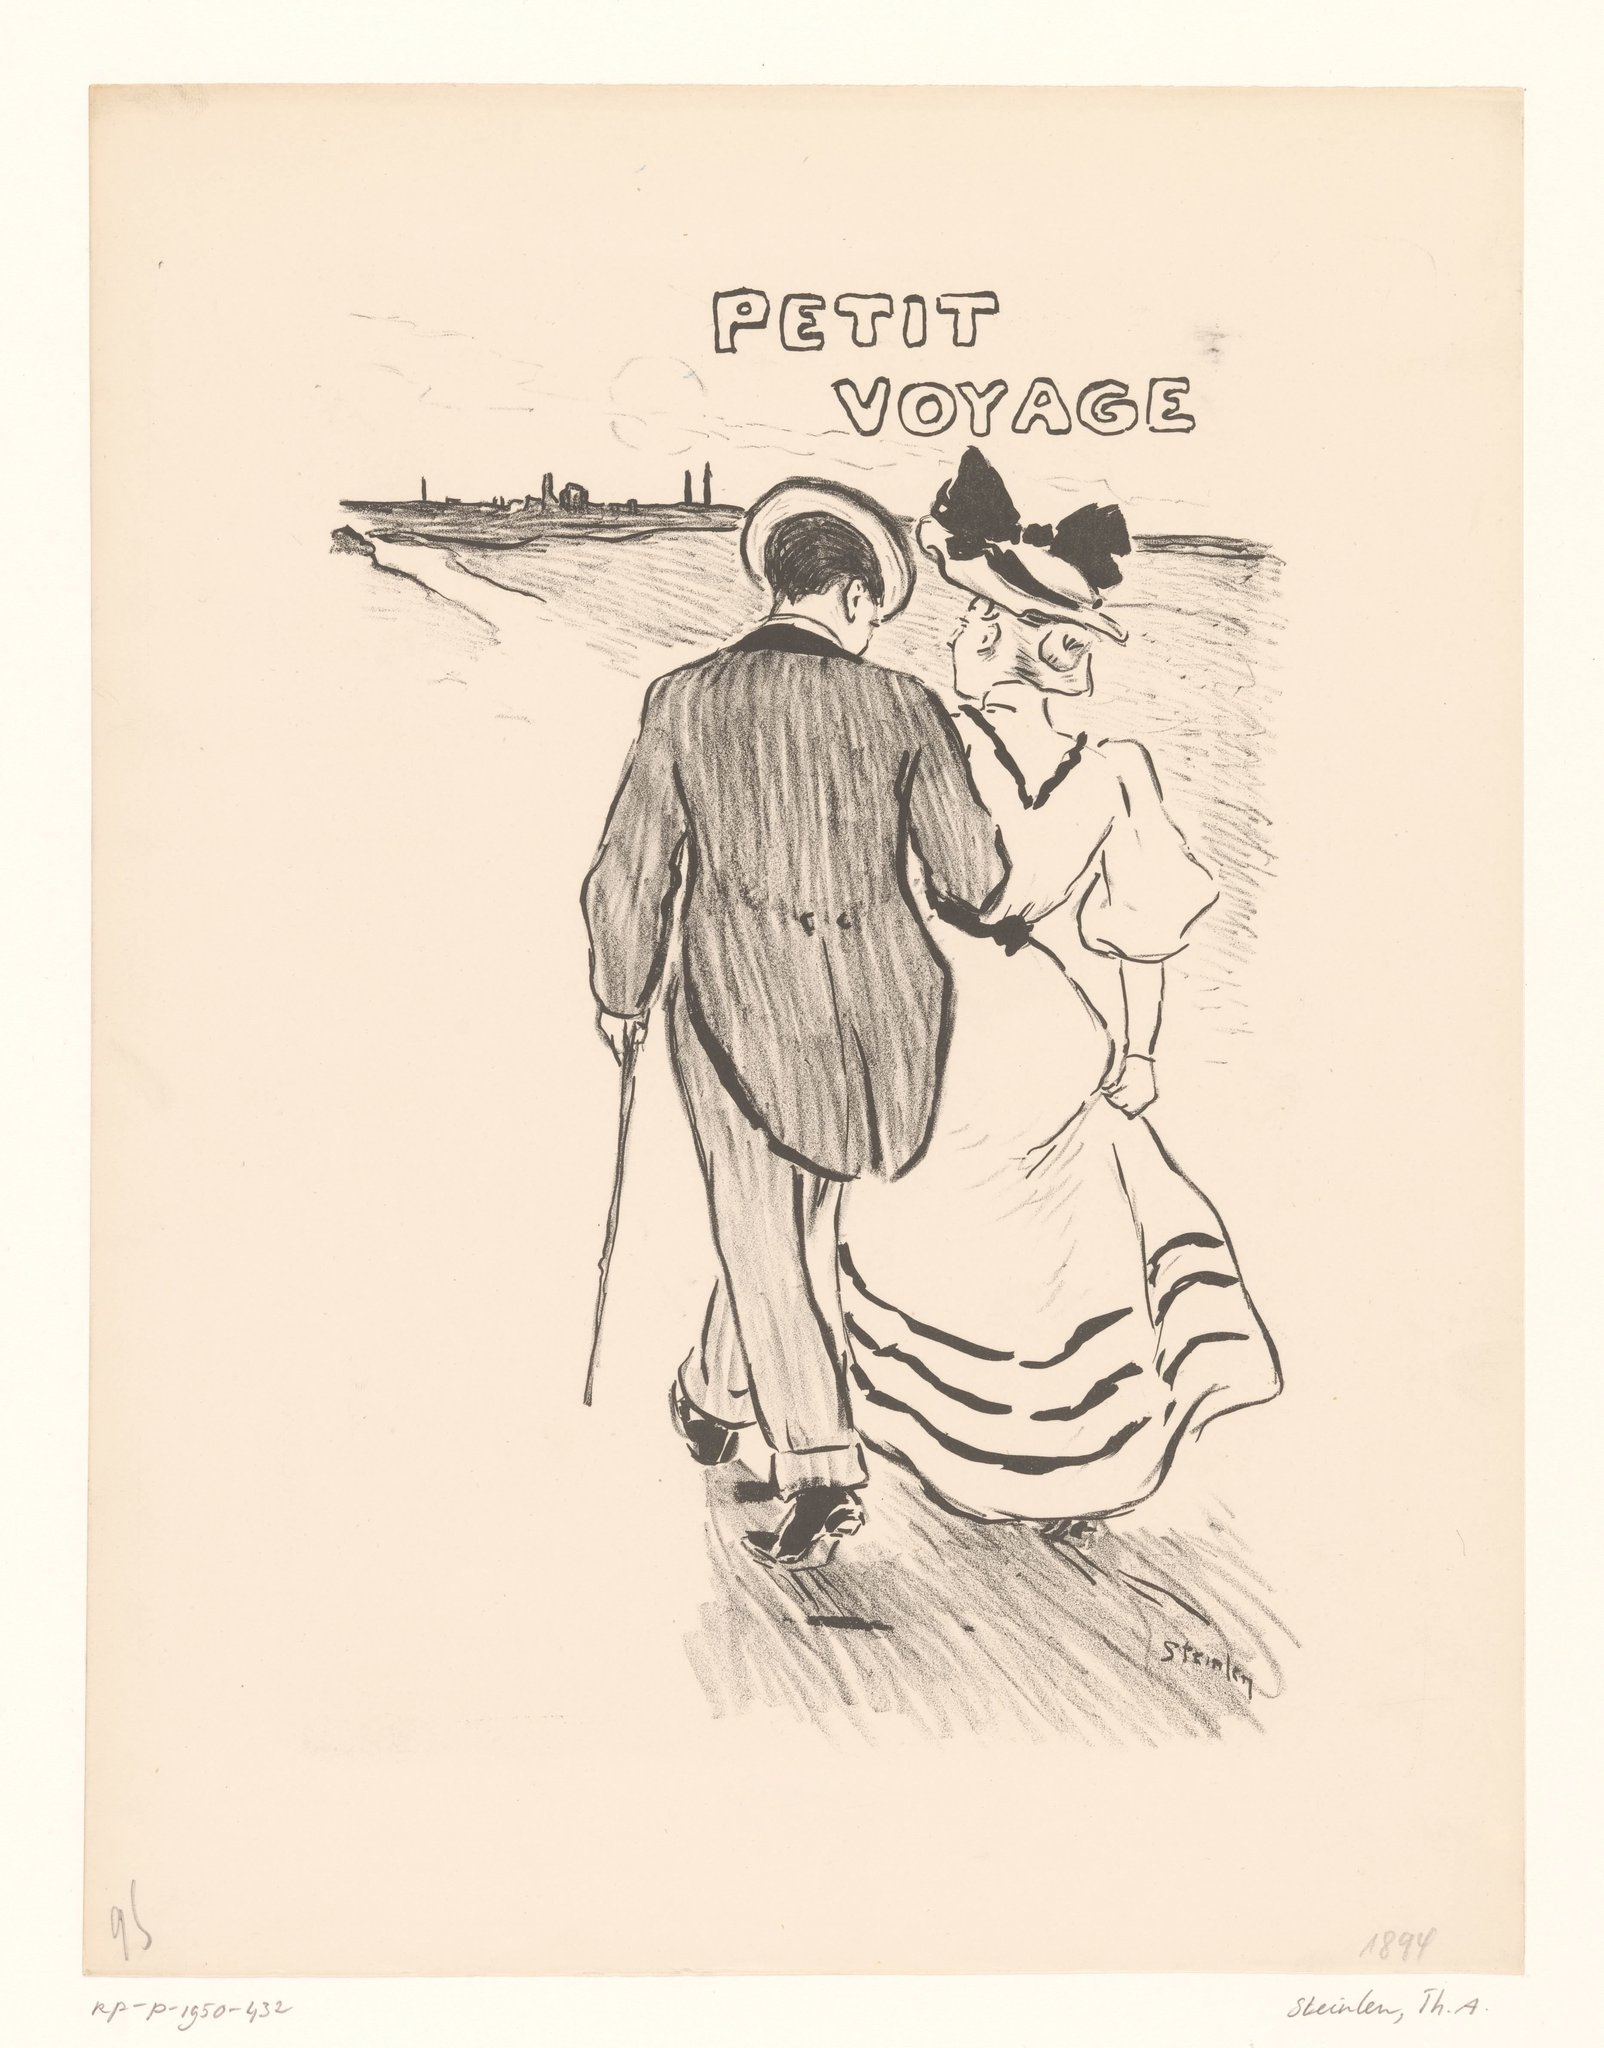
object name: print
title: Petit voyage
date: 1894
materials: paper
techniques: lithograph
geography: paris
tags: fashion, clothing, head-gear, walking-stick, staff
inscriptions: collector's mark: Lugt 2228